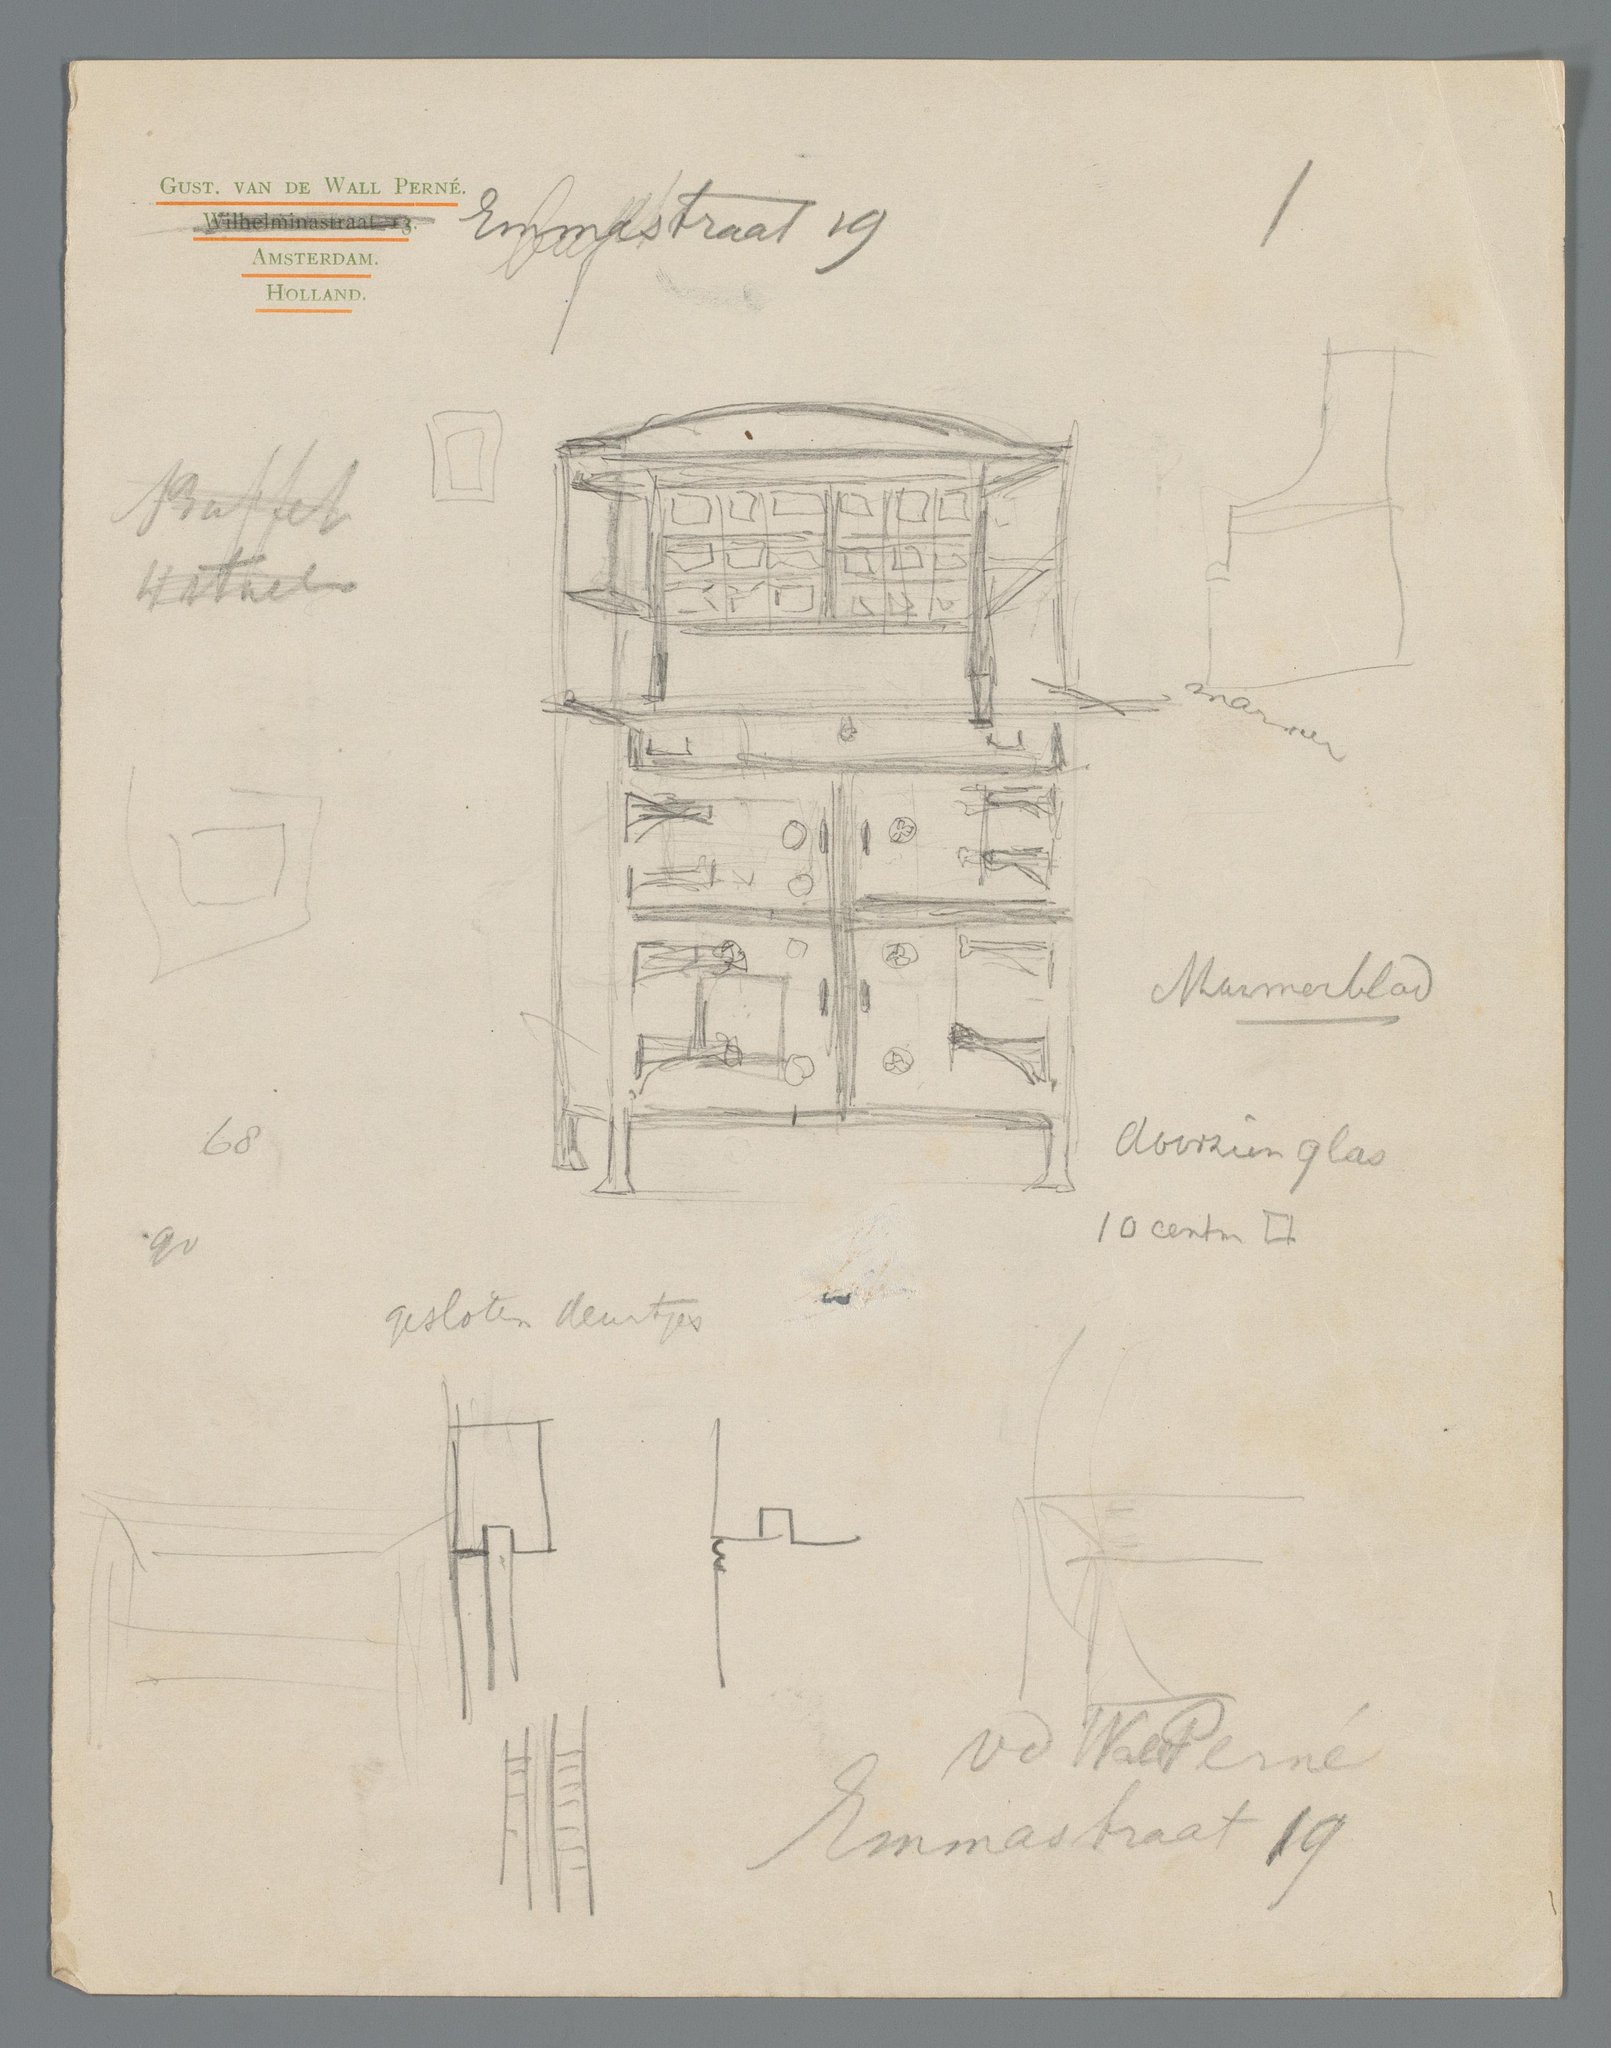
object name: design drawing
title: Ontwerp voor een buffetkast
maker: gust van de wall perné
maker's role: draughtsman, painter, print maker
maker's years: 1877-1911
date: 1887-1911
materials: paper, pencil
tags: ornamental cupboard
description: Met aantekeningen over de afmetingen en de materialen. Op gepersonaliseerd papier.